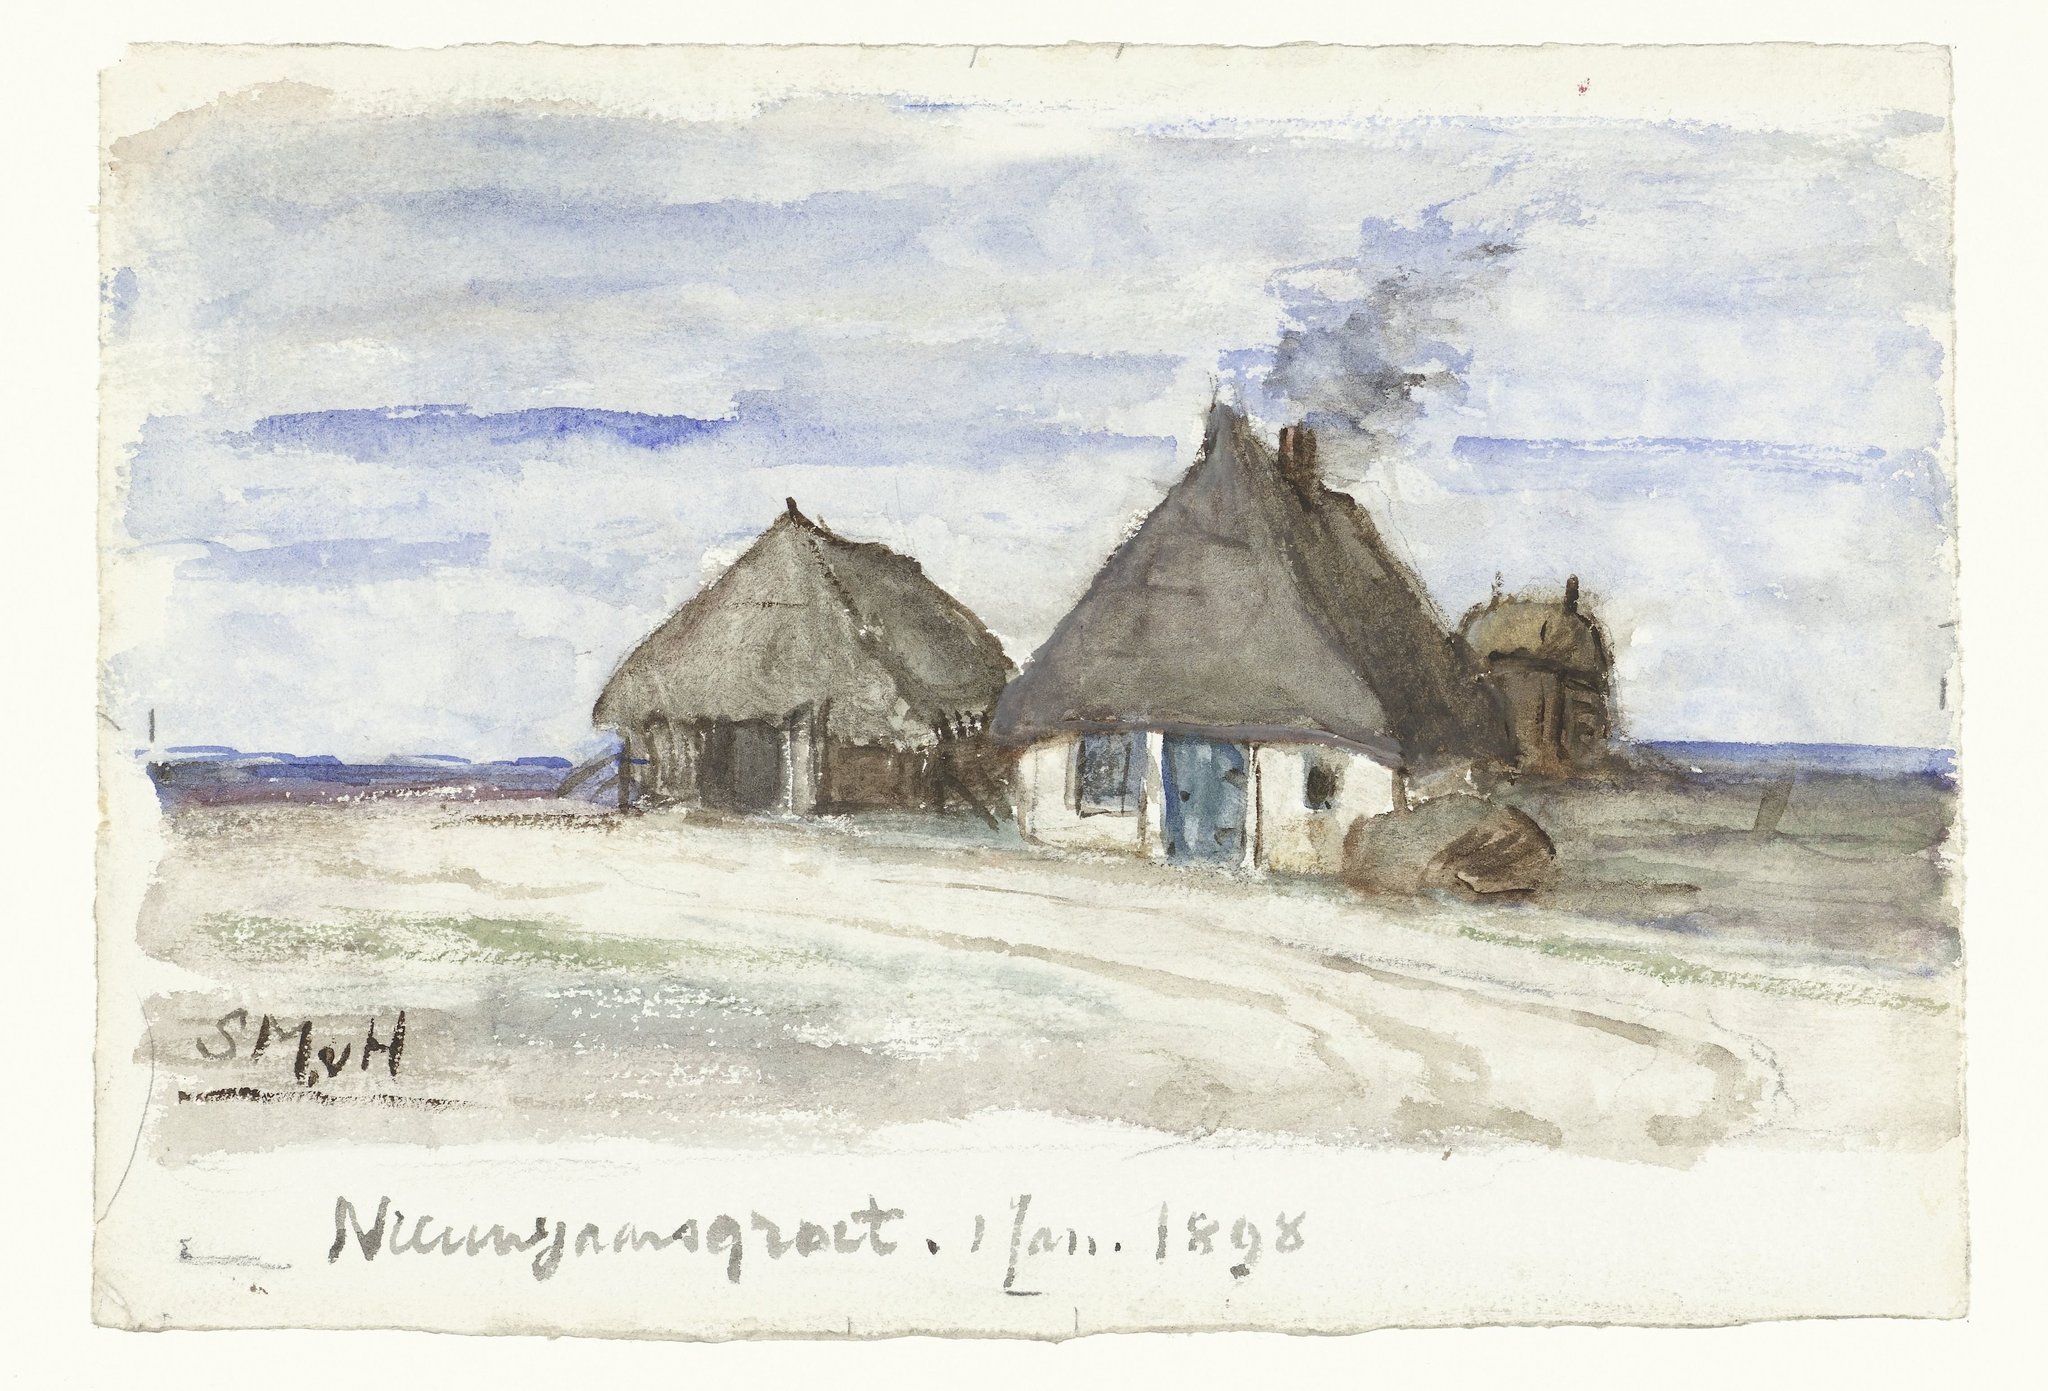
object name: drawing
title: Nieuwjaarsgroet met boerderij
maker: sientje mesdag-van houten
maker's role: draughtsman, painter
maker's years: 1834-1909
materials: paper, pencil, watercolor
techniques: brush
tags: farm (building)